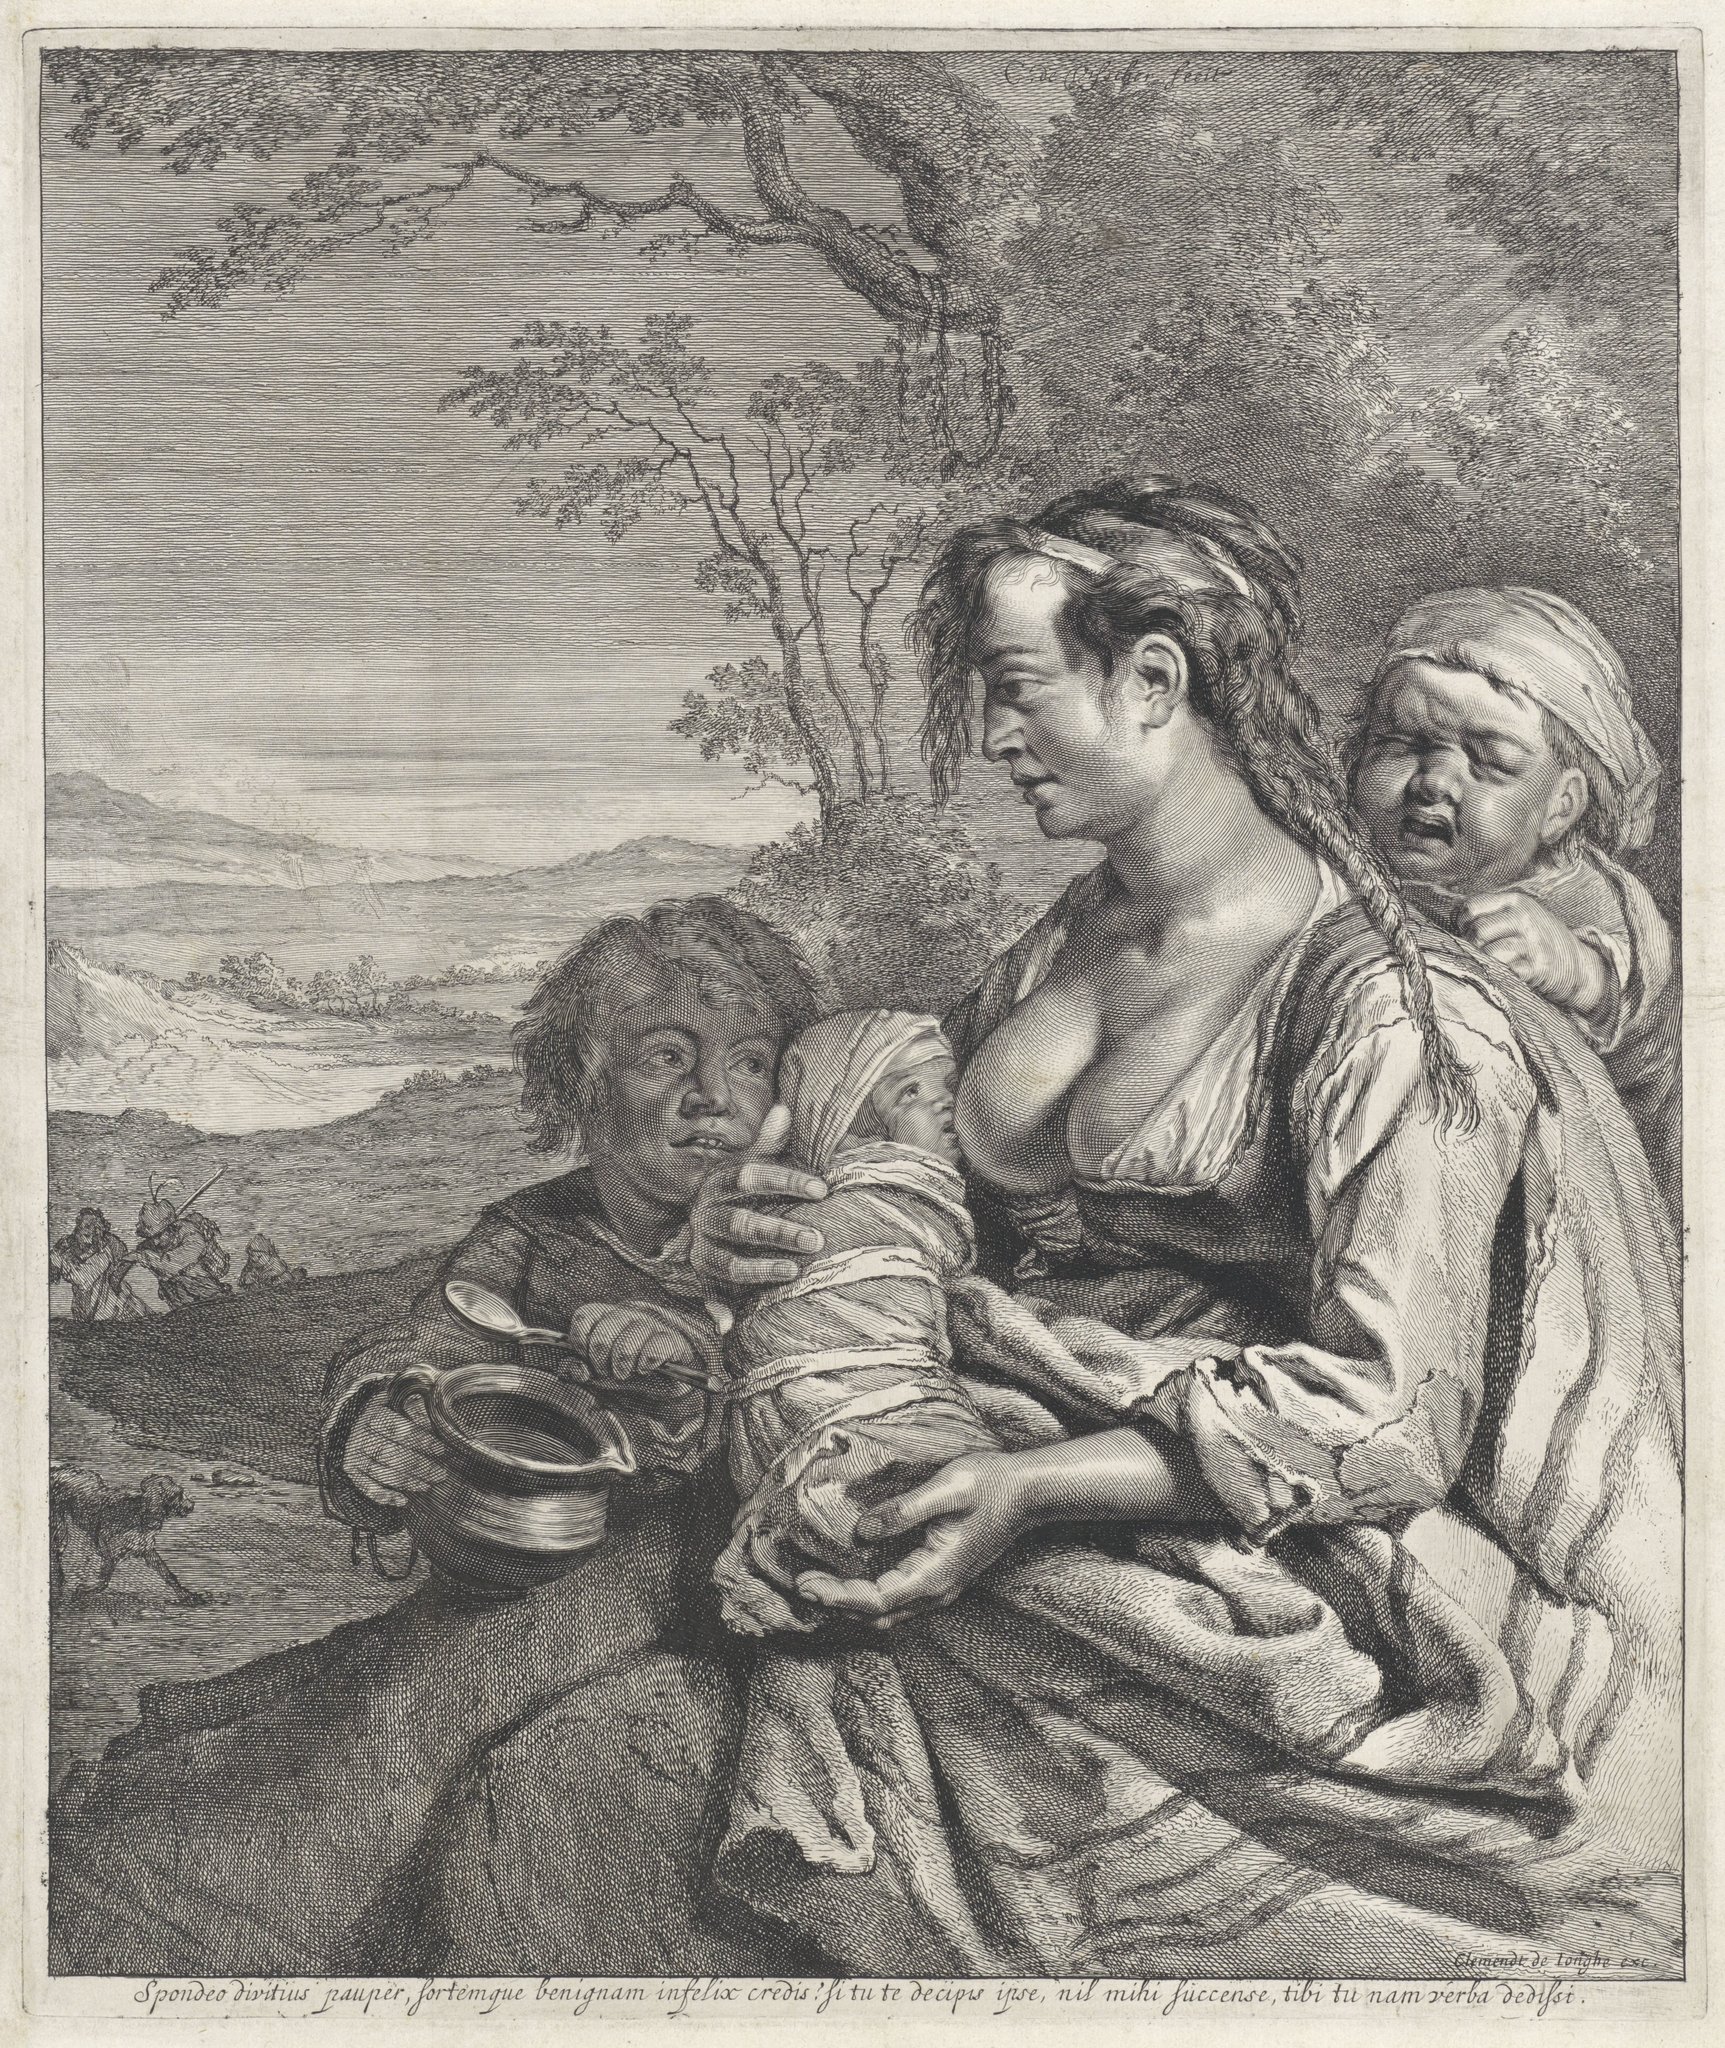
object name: print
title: Roma vrouw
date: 1638-1670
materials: paper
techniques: engraving, etching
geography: amsterdam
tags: nursing, suckling, wandering communities: romani or roma, weeping, 'en route', traveller under way, dog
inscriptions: collector's mark: Lugt 10, collector's mark: Lugt 11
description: In een heuvelachtig landschap geeft een Roma vrouw haar baby de borst. Naast haar staat een jong kind met een nap en een lepel. Op haar rug een derde kind dat huilt. Op de achtergrond drie reizigers en een hond. ‘Heidens’ of ‘heidenen’ was een eigentijdse benaming voor Roma.